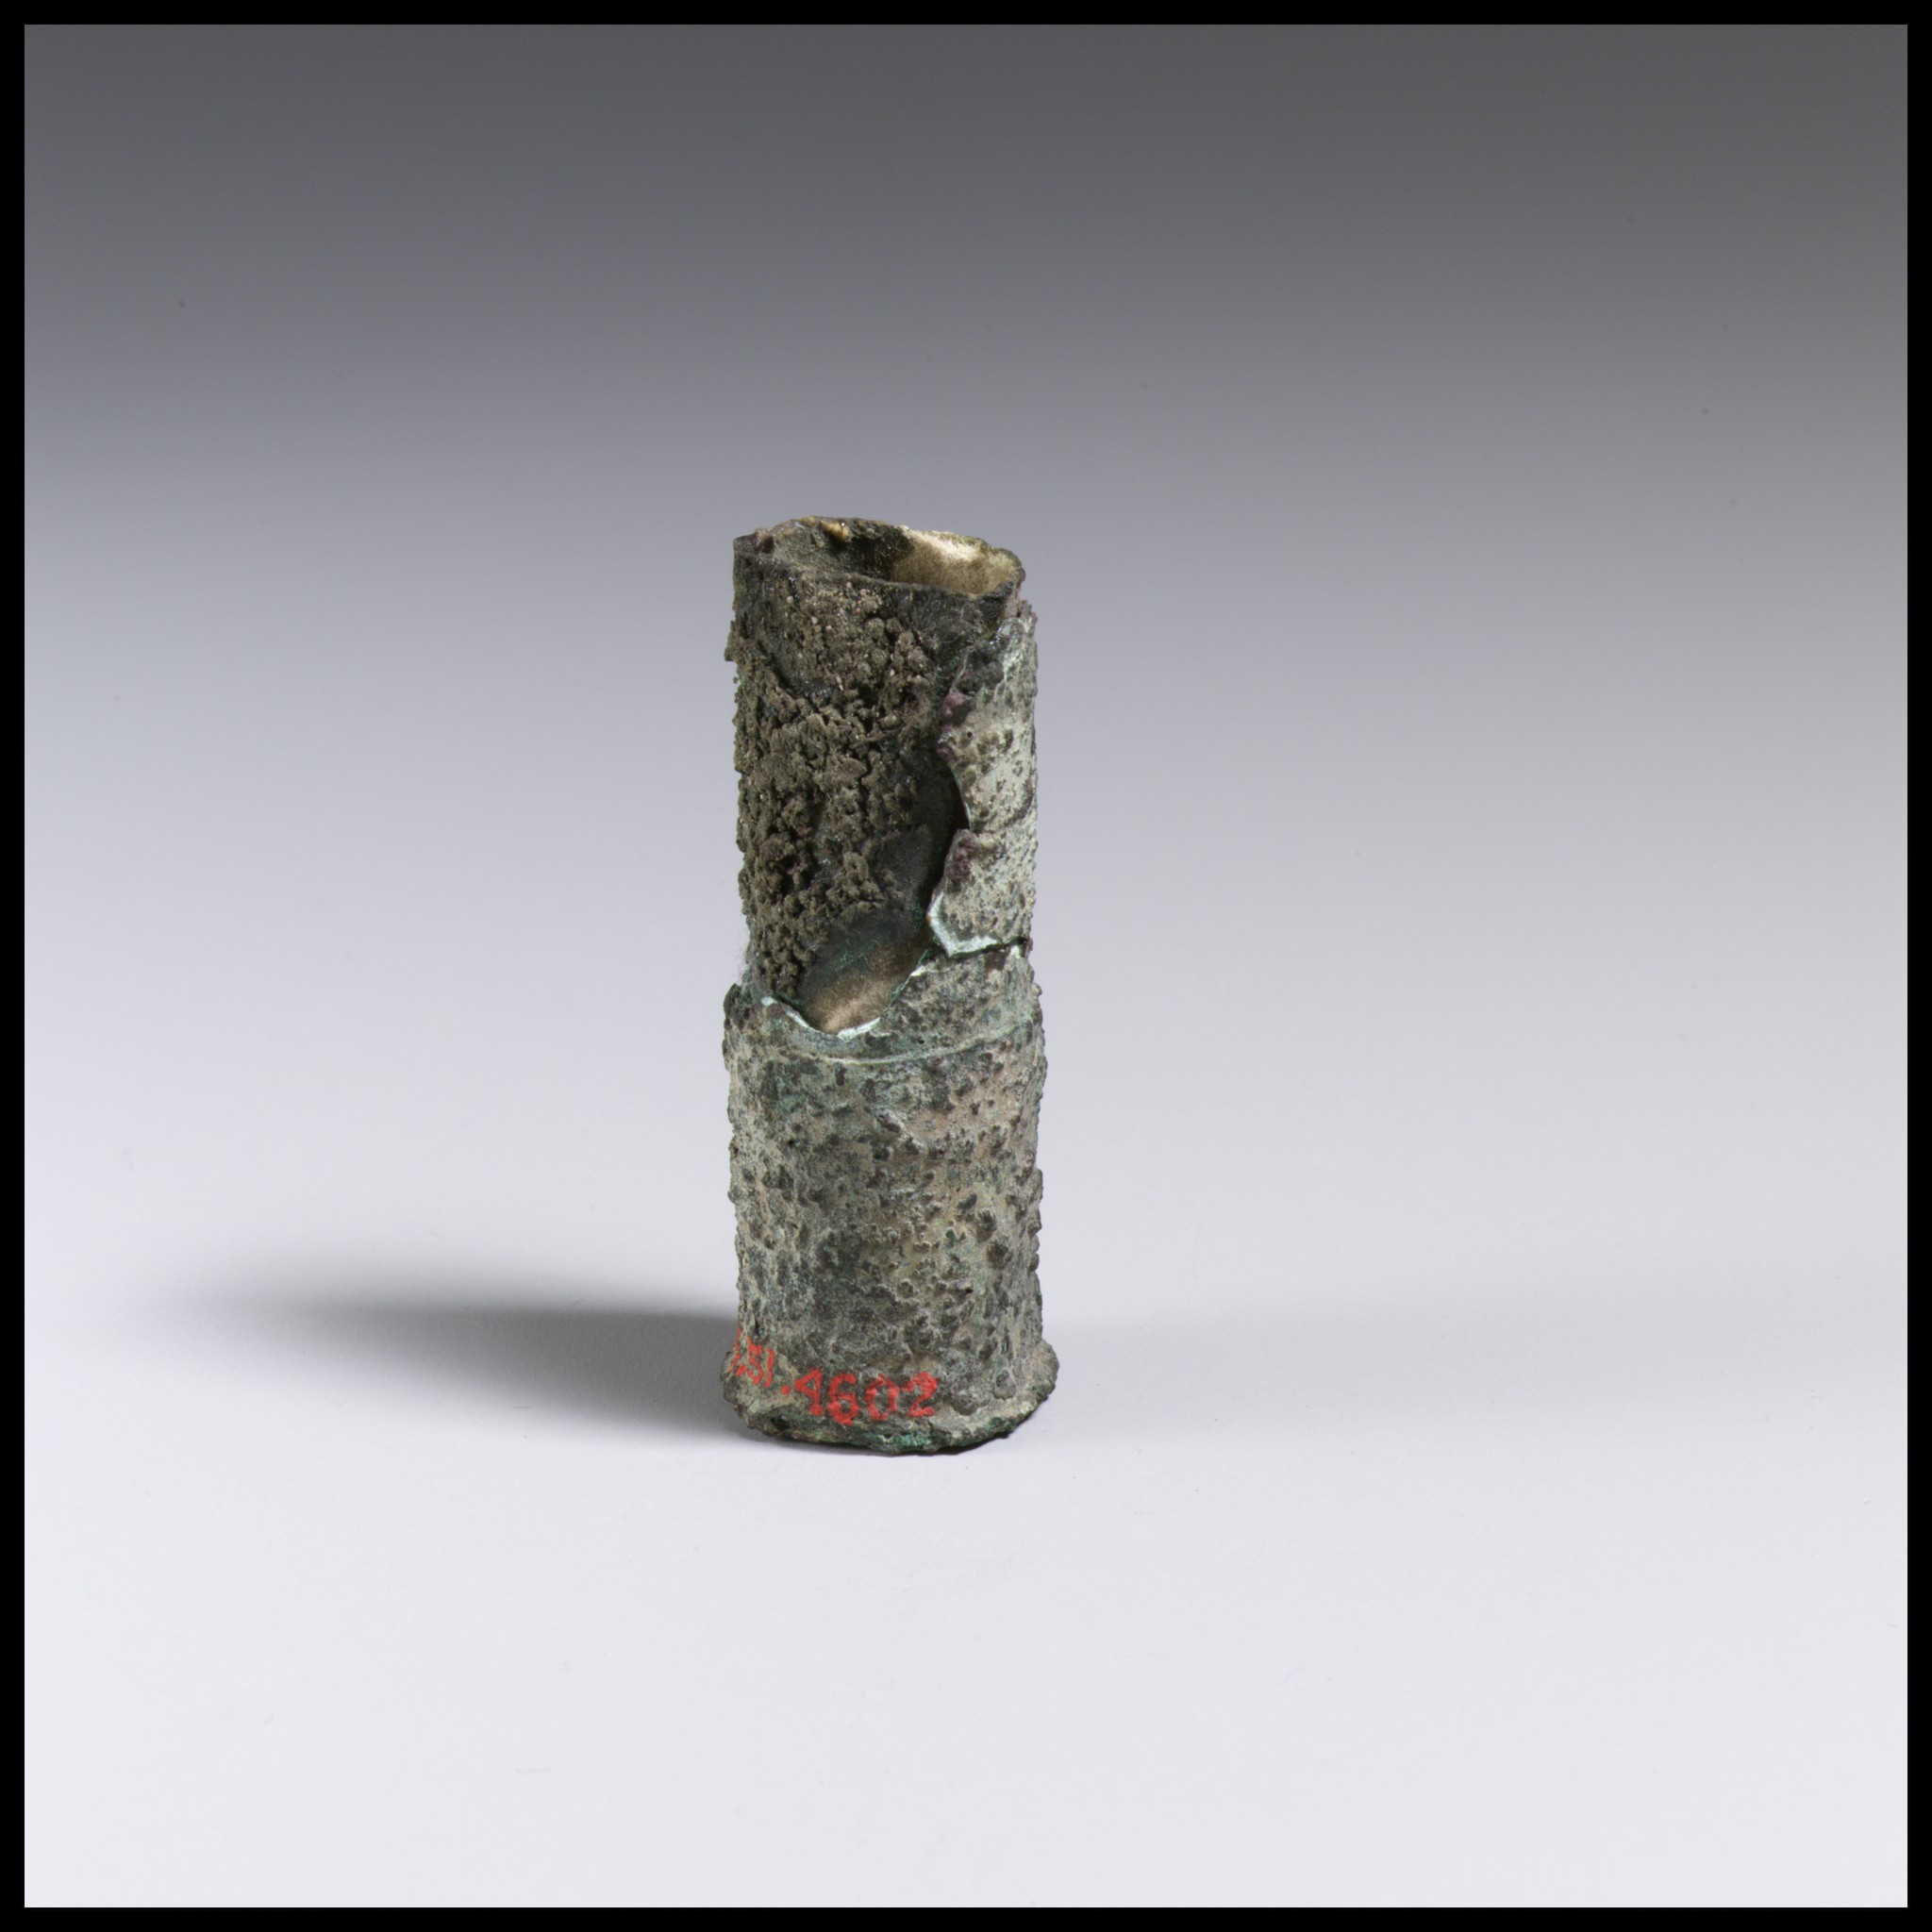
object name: box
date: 7000 BCE-330 CE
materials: bronze